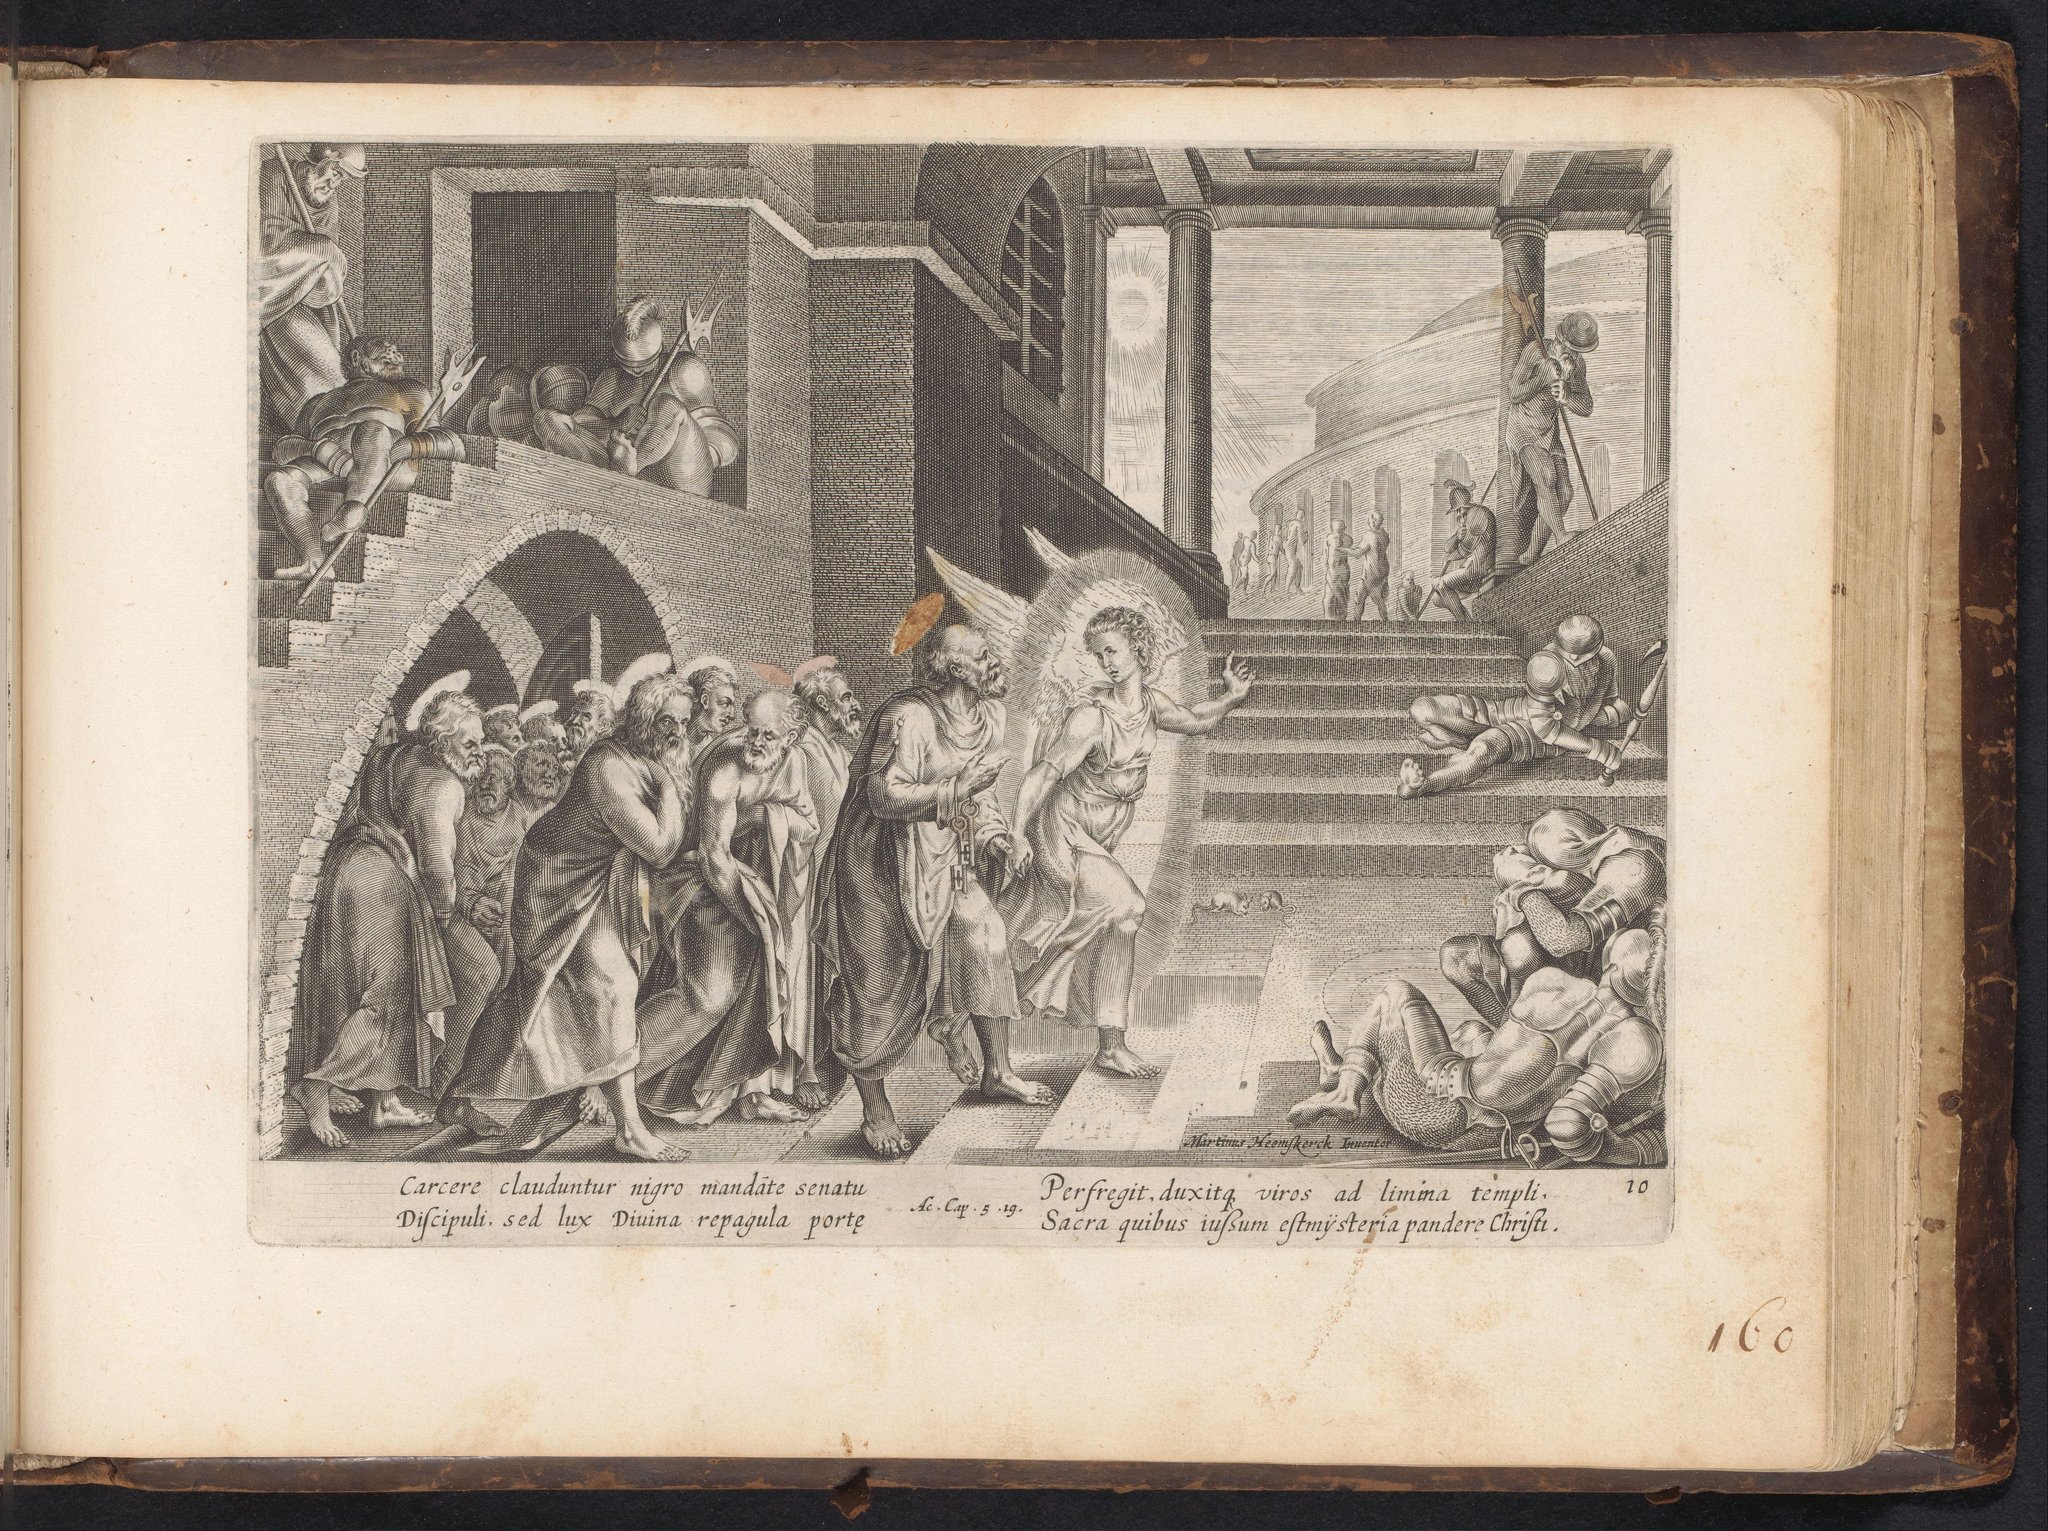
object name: print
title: Petrus en de andere apostelen worden door een engel bevrijd uit de gevangenis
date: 1643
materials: paper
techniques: engraving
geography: alkmaar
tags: at night an angel opens the door of the prison ~ life and acts of peter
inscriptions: number: ‘160’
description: Samen met de andere apostelen wordt Petrus bevrijd uit de gevangenis door een engel. Soldaten die de gevangenen bewaakten, zijn allemaal in slaap gevallen. Onder de voorstelling een verwijzing in het Latijn naar de Bijbeltekst in Hand. 5:19. Deze prent maakt deel uit van een album.